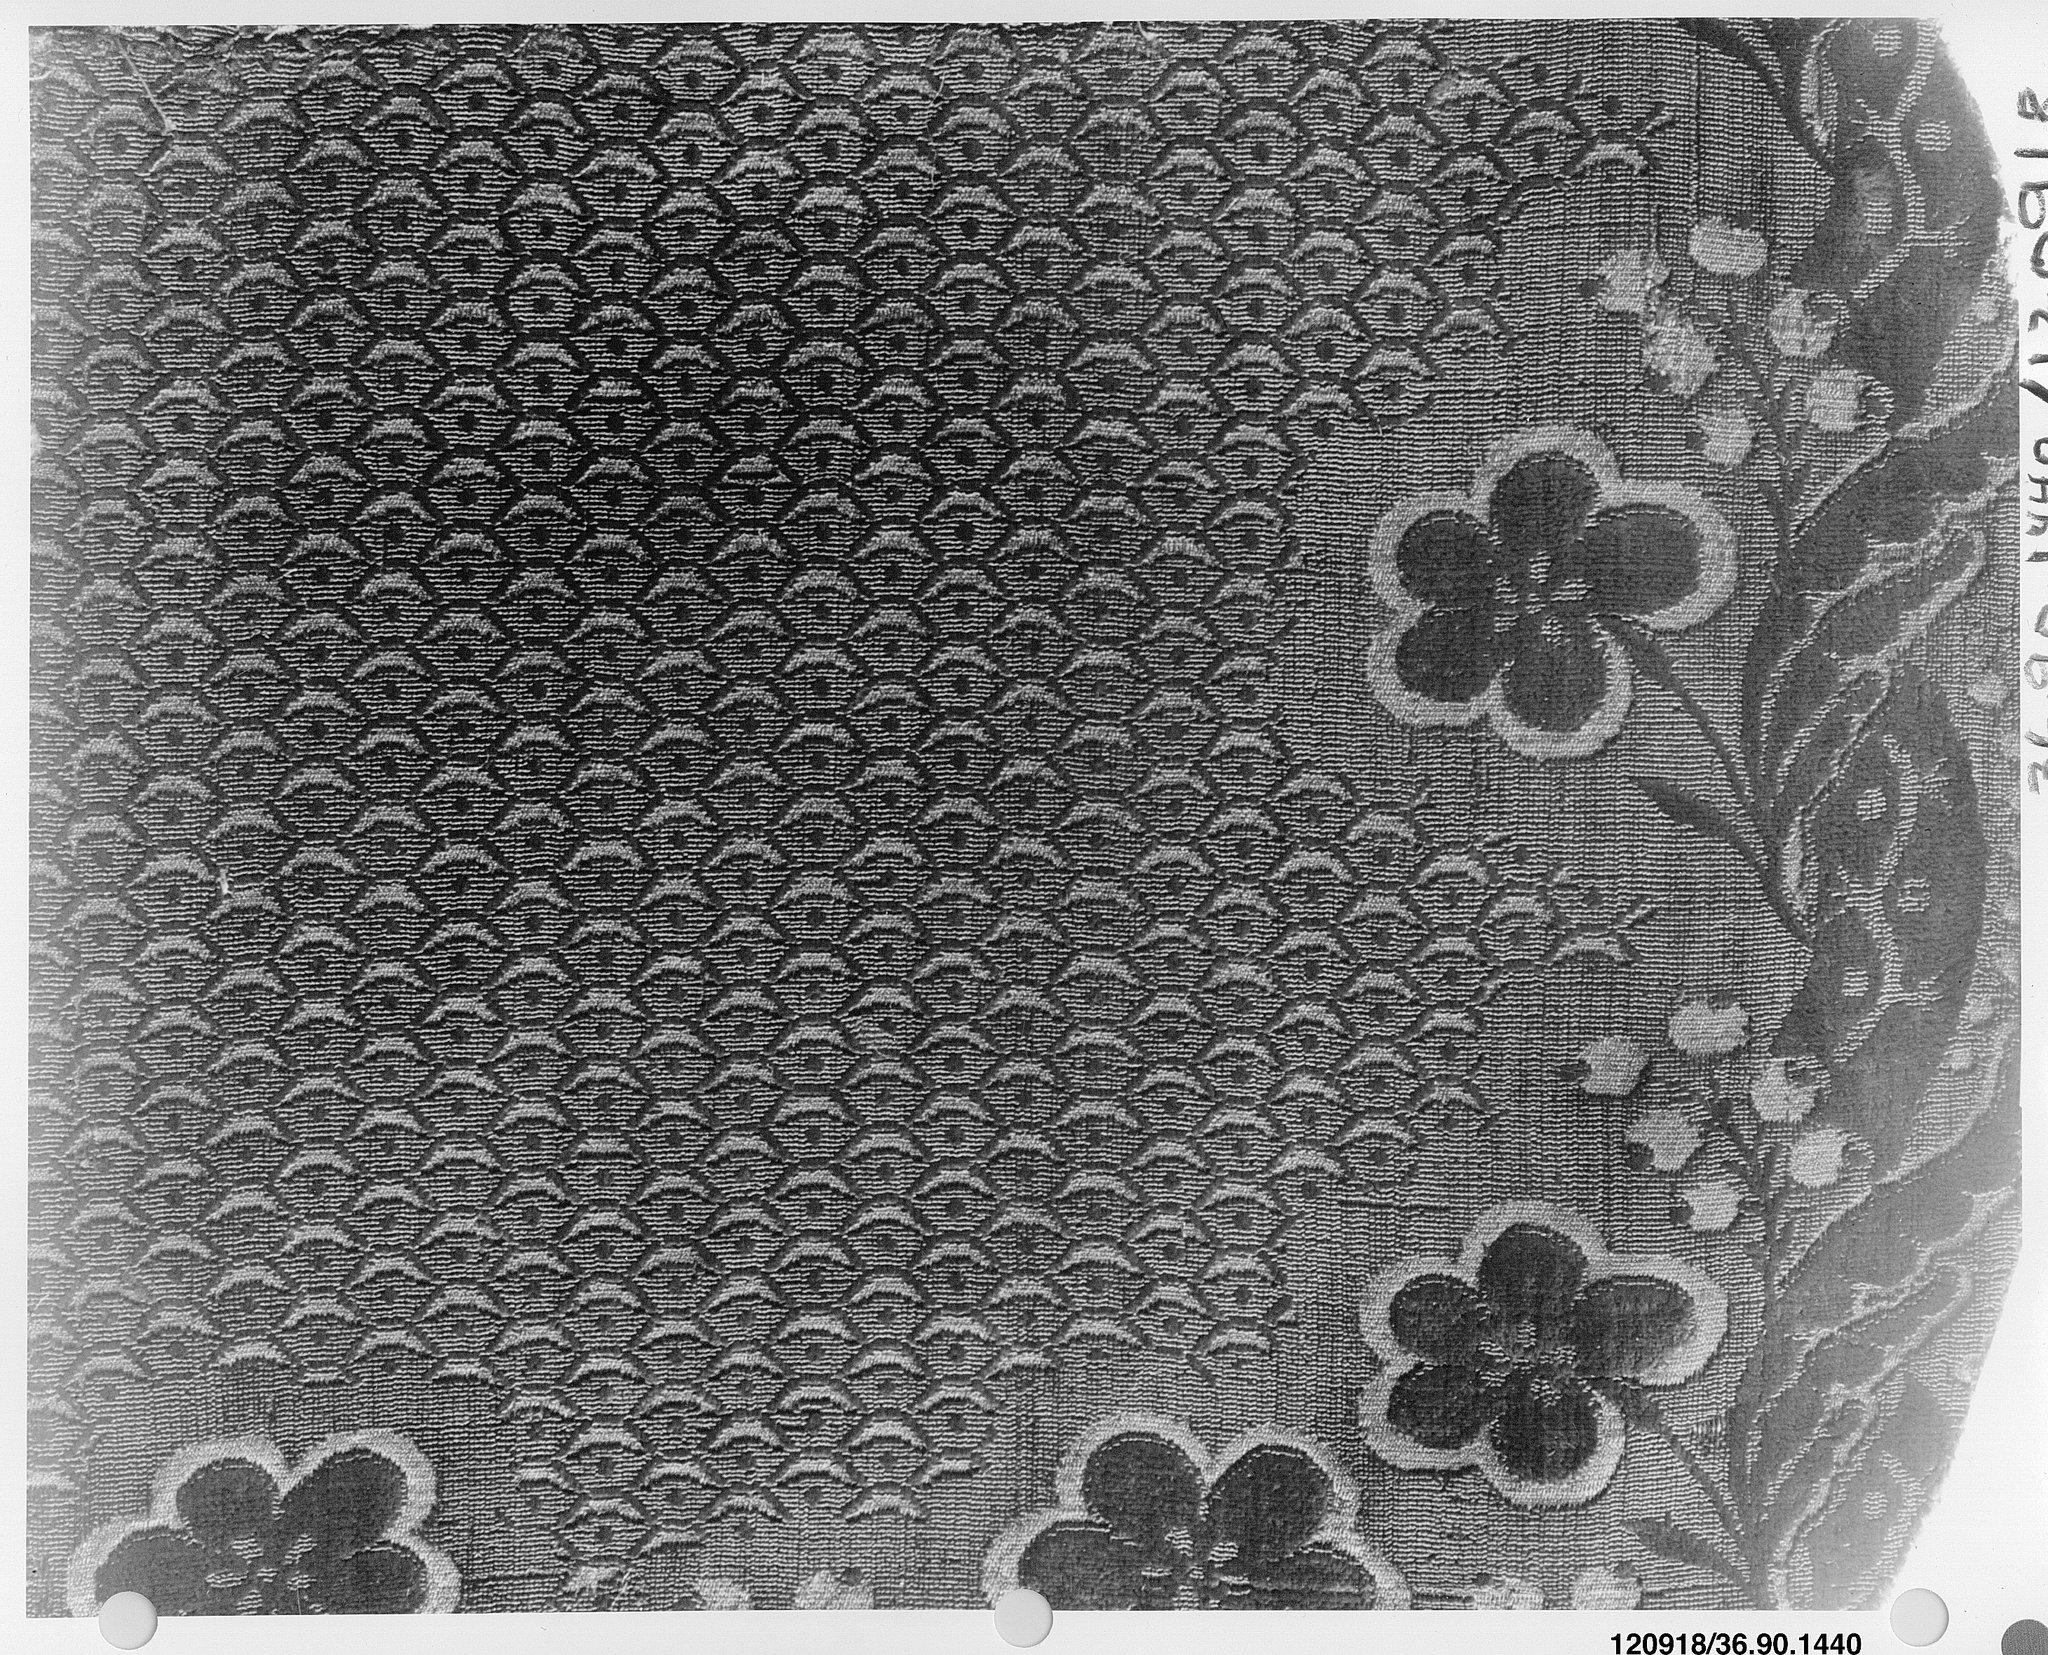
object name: piece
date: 1701-1800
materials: silk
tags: flowers